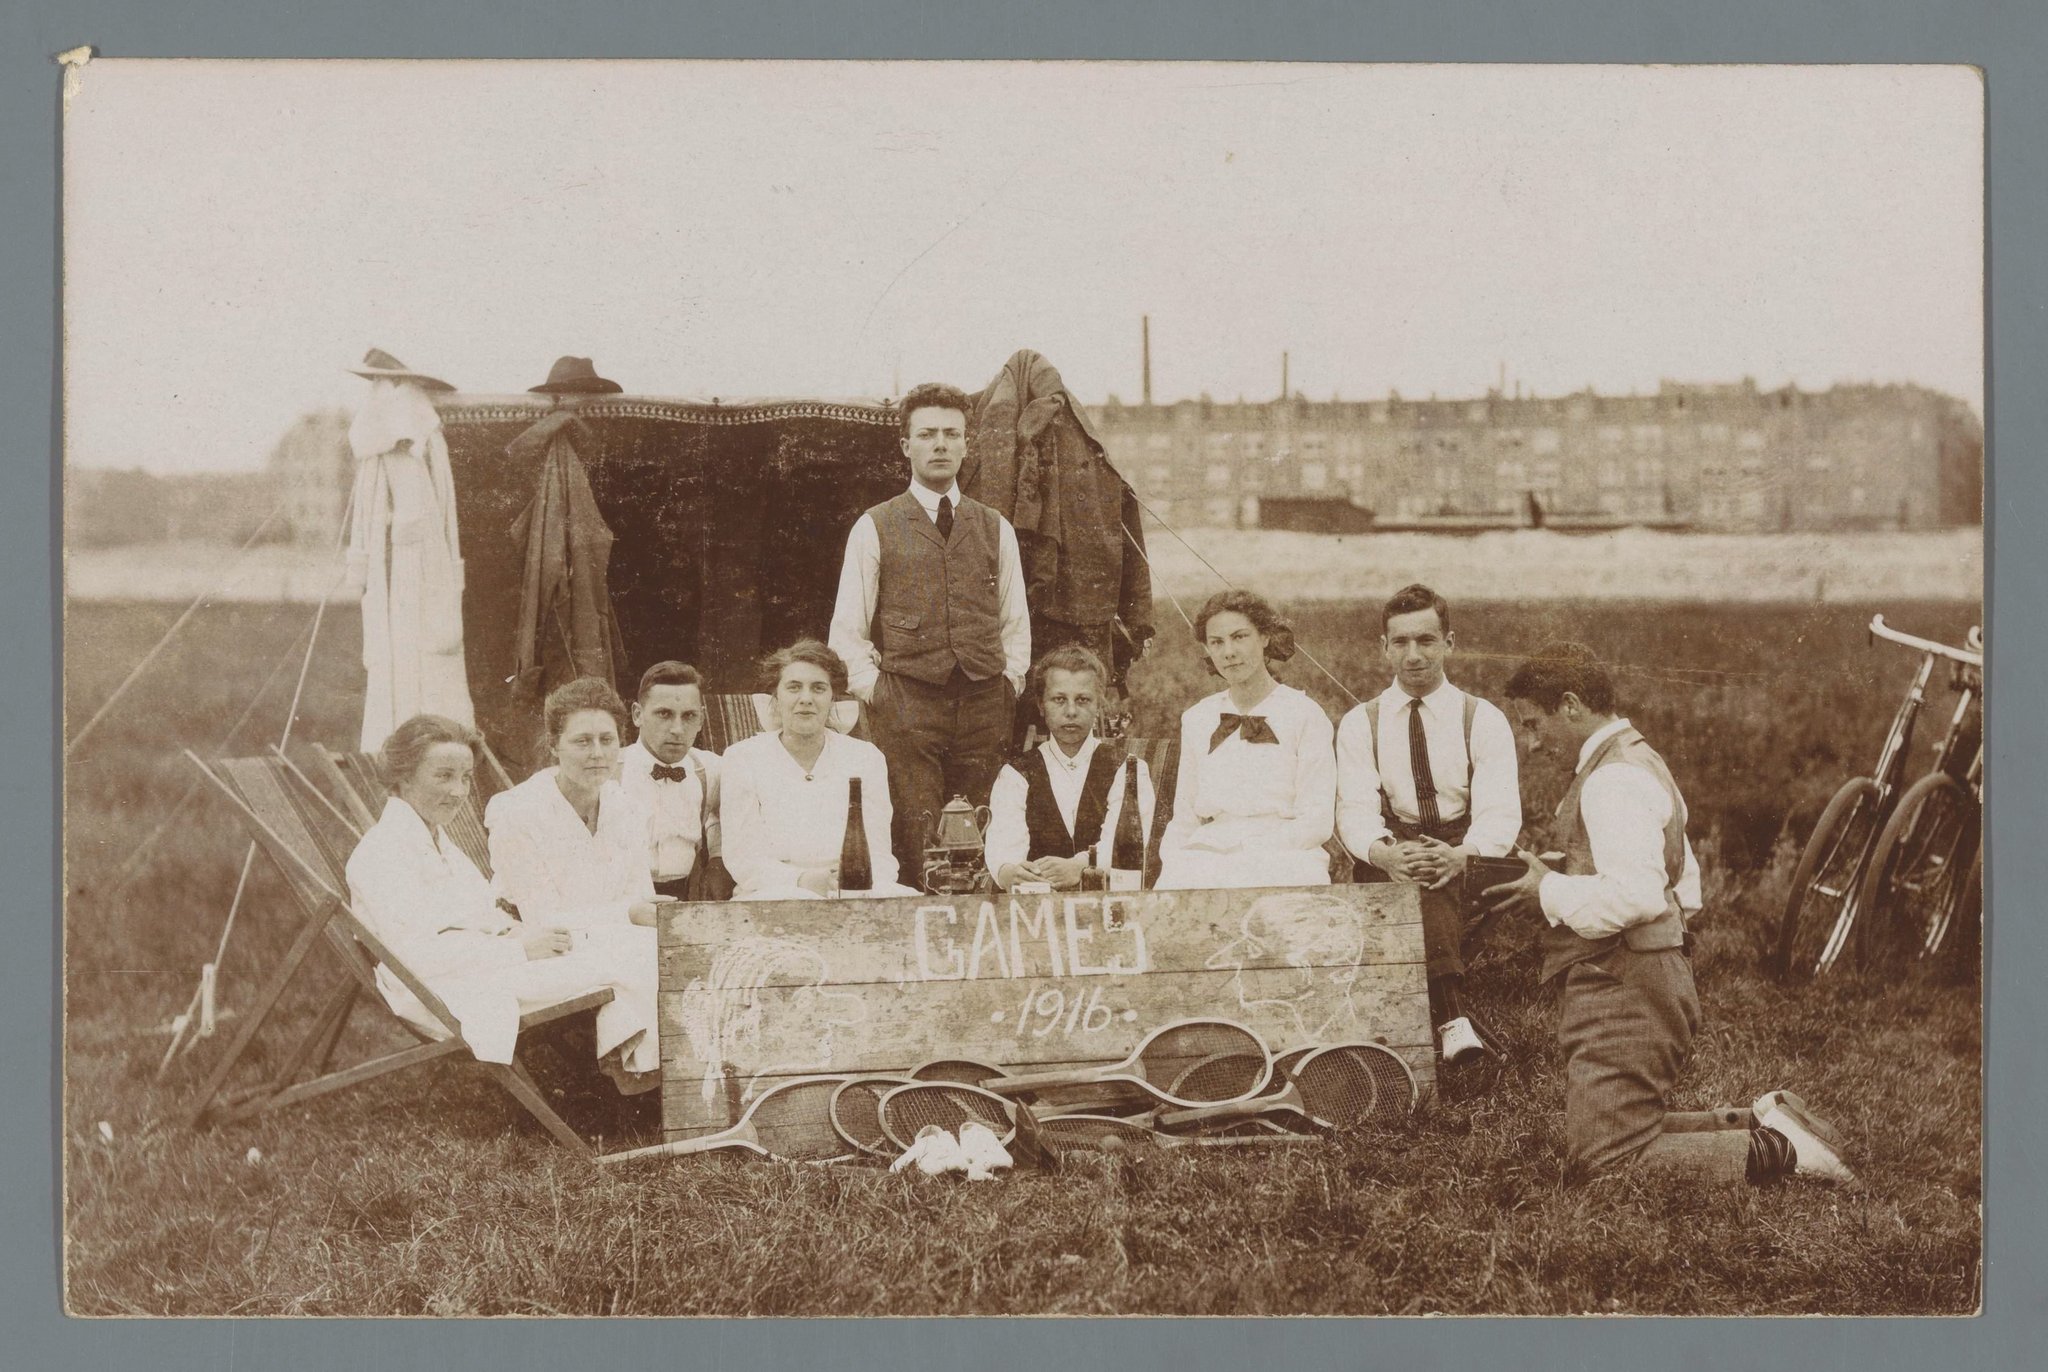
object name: ansichtkaart, prentbriefkaart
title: Groepsportret van onbekende mannen en vrouwen met tennisrackets en rechts een amateurfotograaf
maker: Anonymous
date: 1916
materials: photographic support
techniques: collodion silver print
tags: tennis, lawn-tennis, taking photographs - cc - out of doors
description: Op het bord waar het gezelschap achter zit staat: Games 1916.